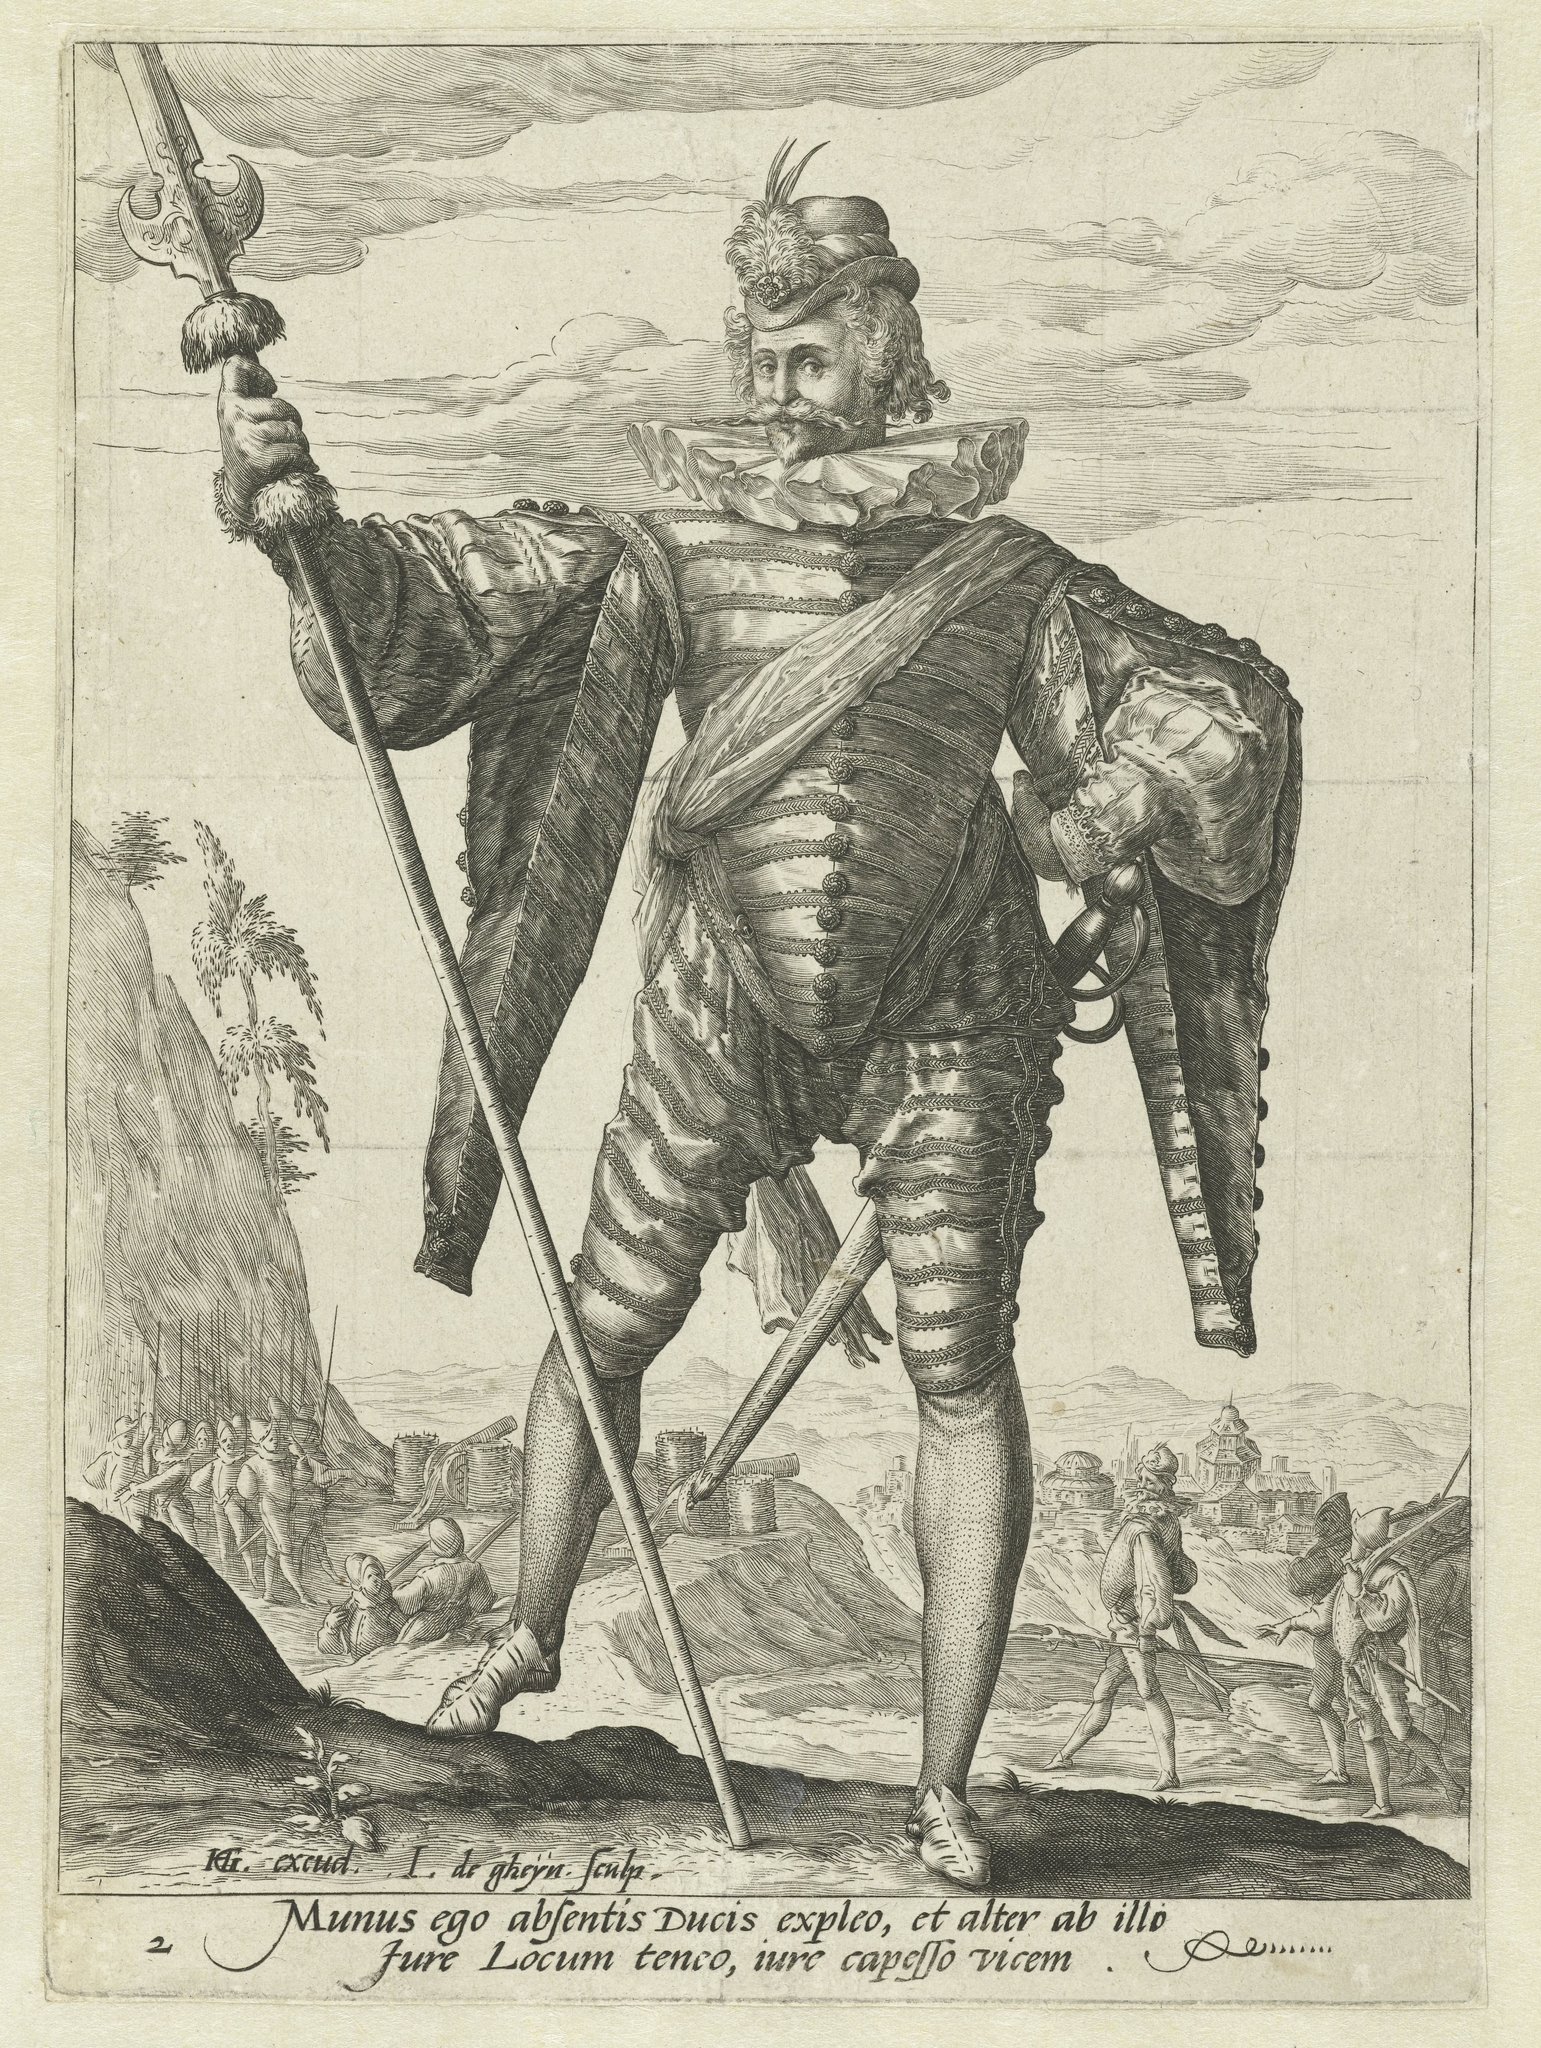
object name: print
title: Officieren en soldaten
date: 1587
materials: paper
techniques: engraving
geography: haarlem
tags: neck-gear ~ clothing (with name) (+ men's clothes), clothing for the upper part of the body (with name) (+ men's clothes), shoulder-belt, bandoleer (+ men's clothes), head-gear: toque (+ men's clothes), siege, position war, sleeves, shoes, sandals (+ men's clothes), clothes, costume (+ men's clothes), officer, trousers, breeches, etc. (breeches) (+ men's clothes), clothing for the upper part of the body (doublet) (+ men's clothes), sleeves (+ men's clothes), helved weapons, polearms (for striking, hacking, thrusting): halberd, low countries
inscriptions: collector's mark: Lugt 240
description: Een man in militaire uitdossing (een luitenant-kolonel), ten voeten uit, een zwaard aan zijn gordel, een stokwapen (partizaan) in zijn rechterhand. Op de achtergrond een heuvelachtig landschap waarin een stad belegerd wordt. Onder de voorstelling twee regels tekst in Latijn. Deze prent is onderdeel van een serie van 12 genummerde prenten van militairen, ten voeten uit weergegeven tegen een landschappelijke achtergrond waarin krijgshandelingen verricht worden, en met een tweeregelig Latijns onderschrift.